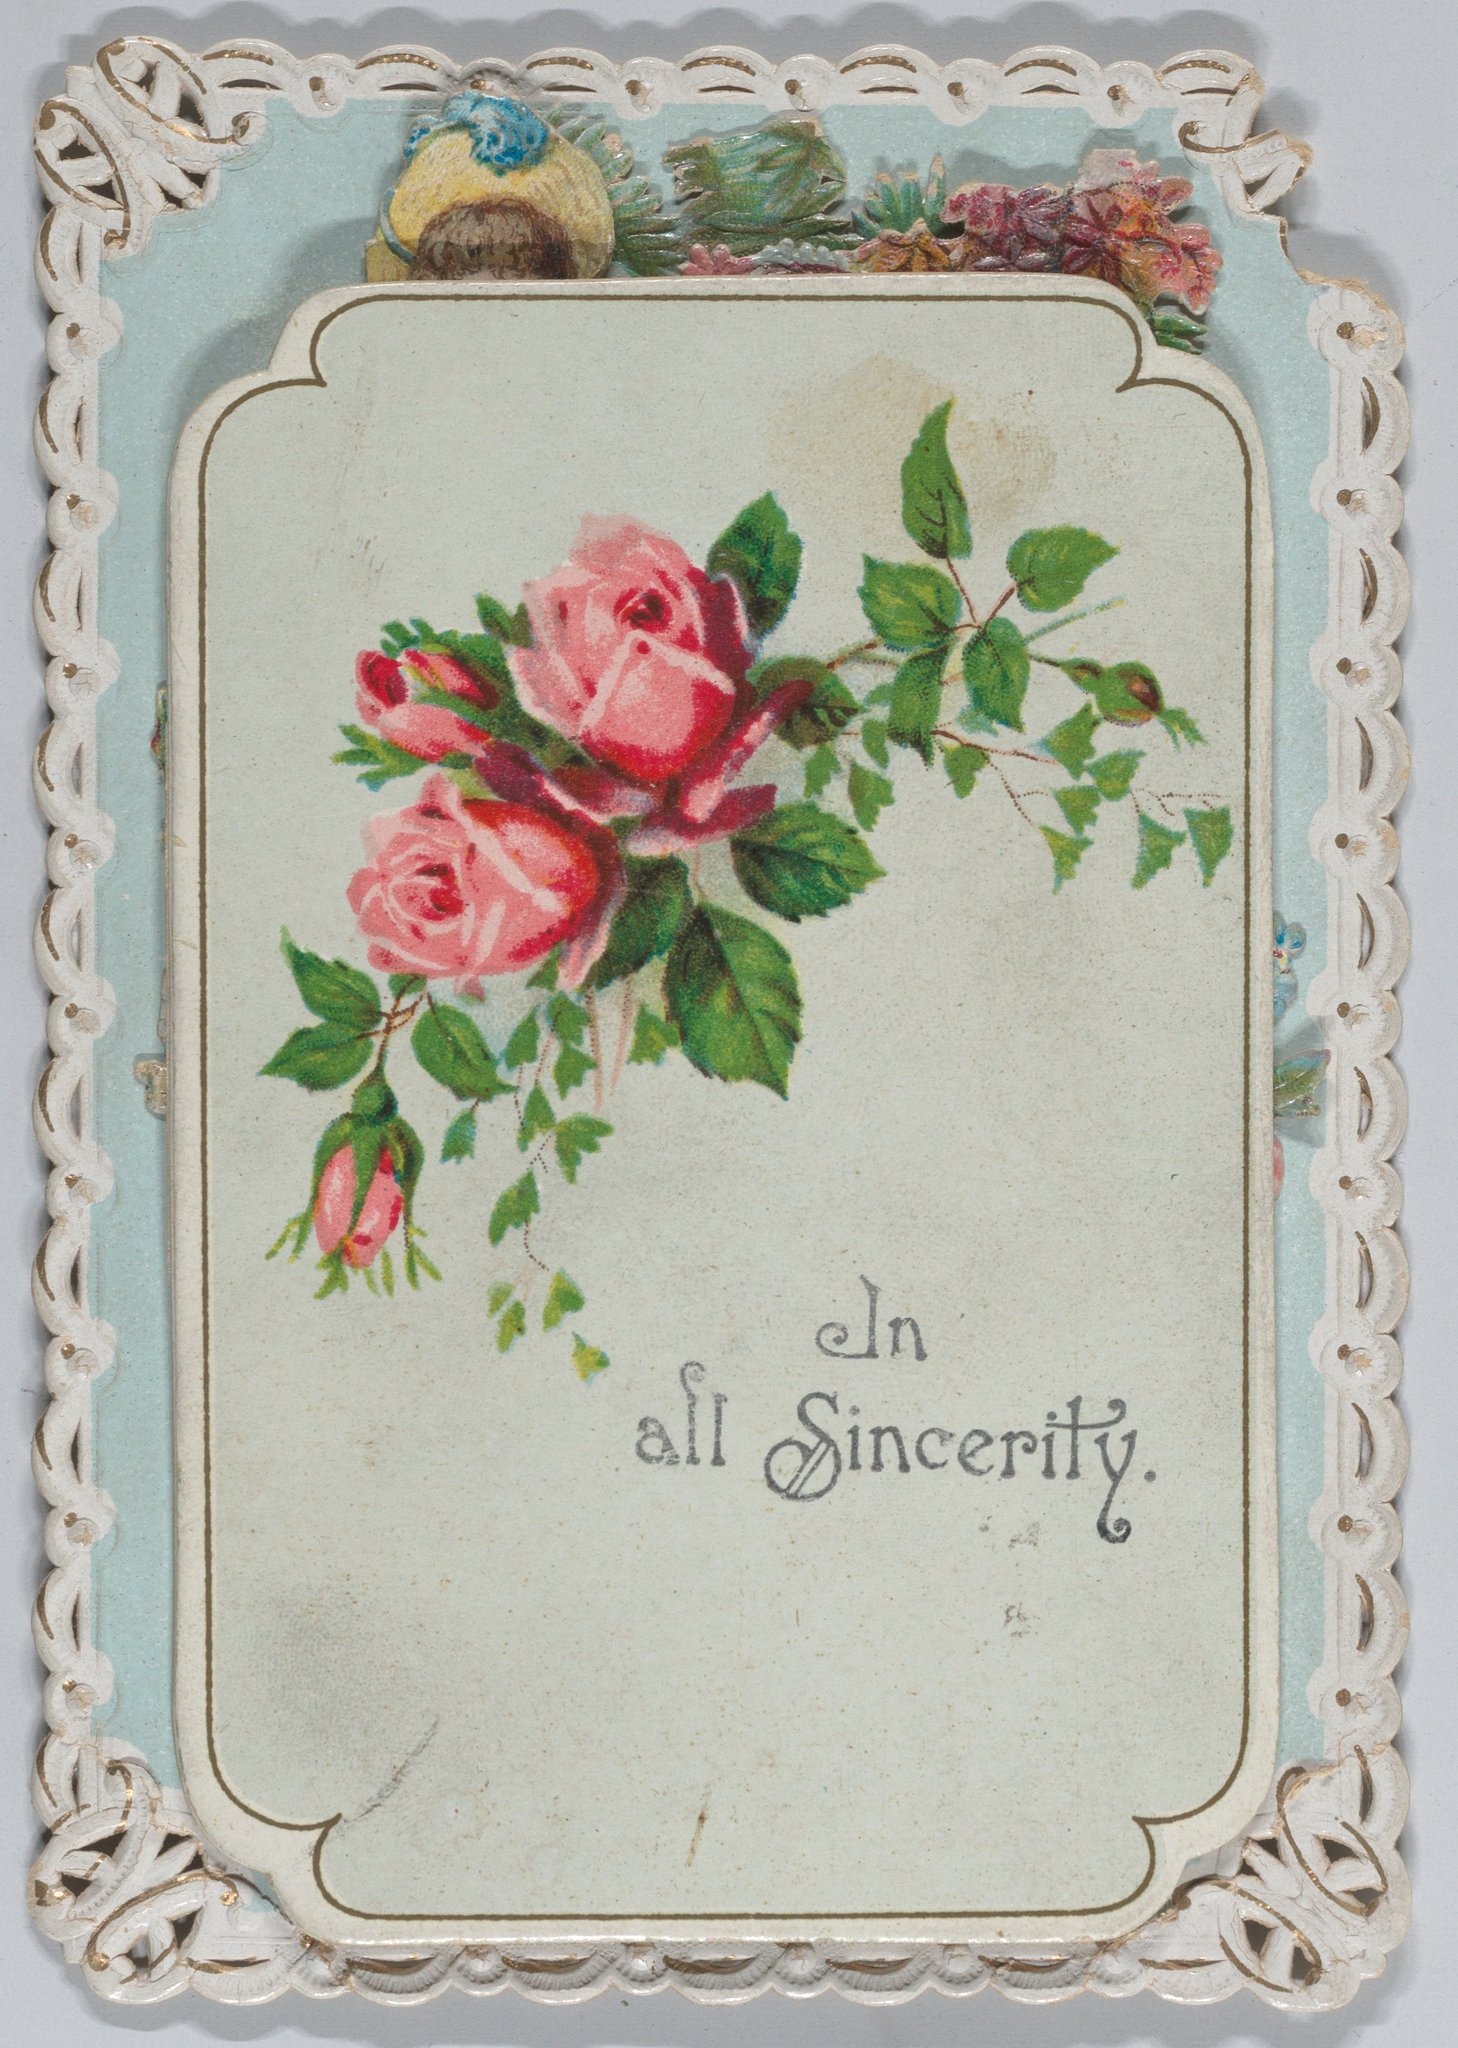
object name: valentine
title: Valentine - Mechanical pull down - Woman on a garden bench with cascade and doves.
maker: Anonymous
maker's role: artist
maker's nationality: british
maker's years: 1800-1899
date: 1875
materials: paper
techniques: chromolithography, cutting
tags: flowers